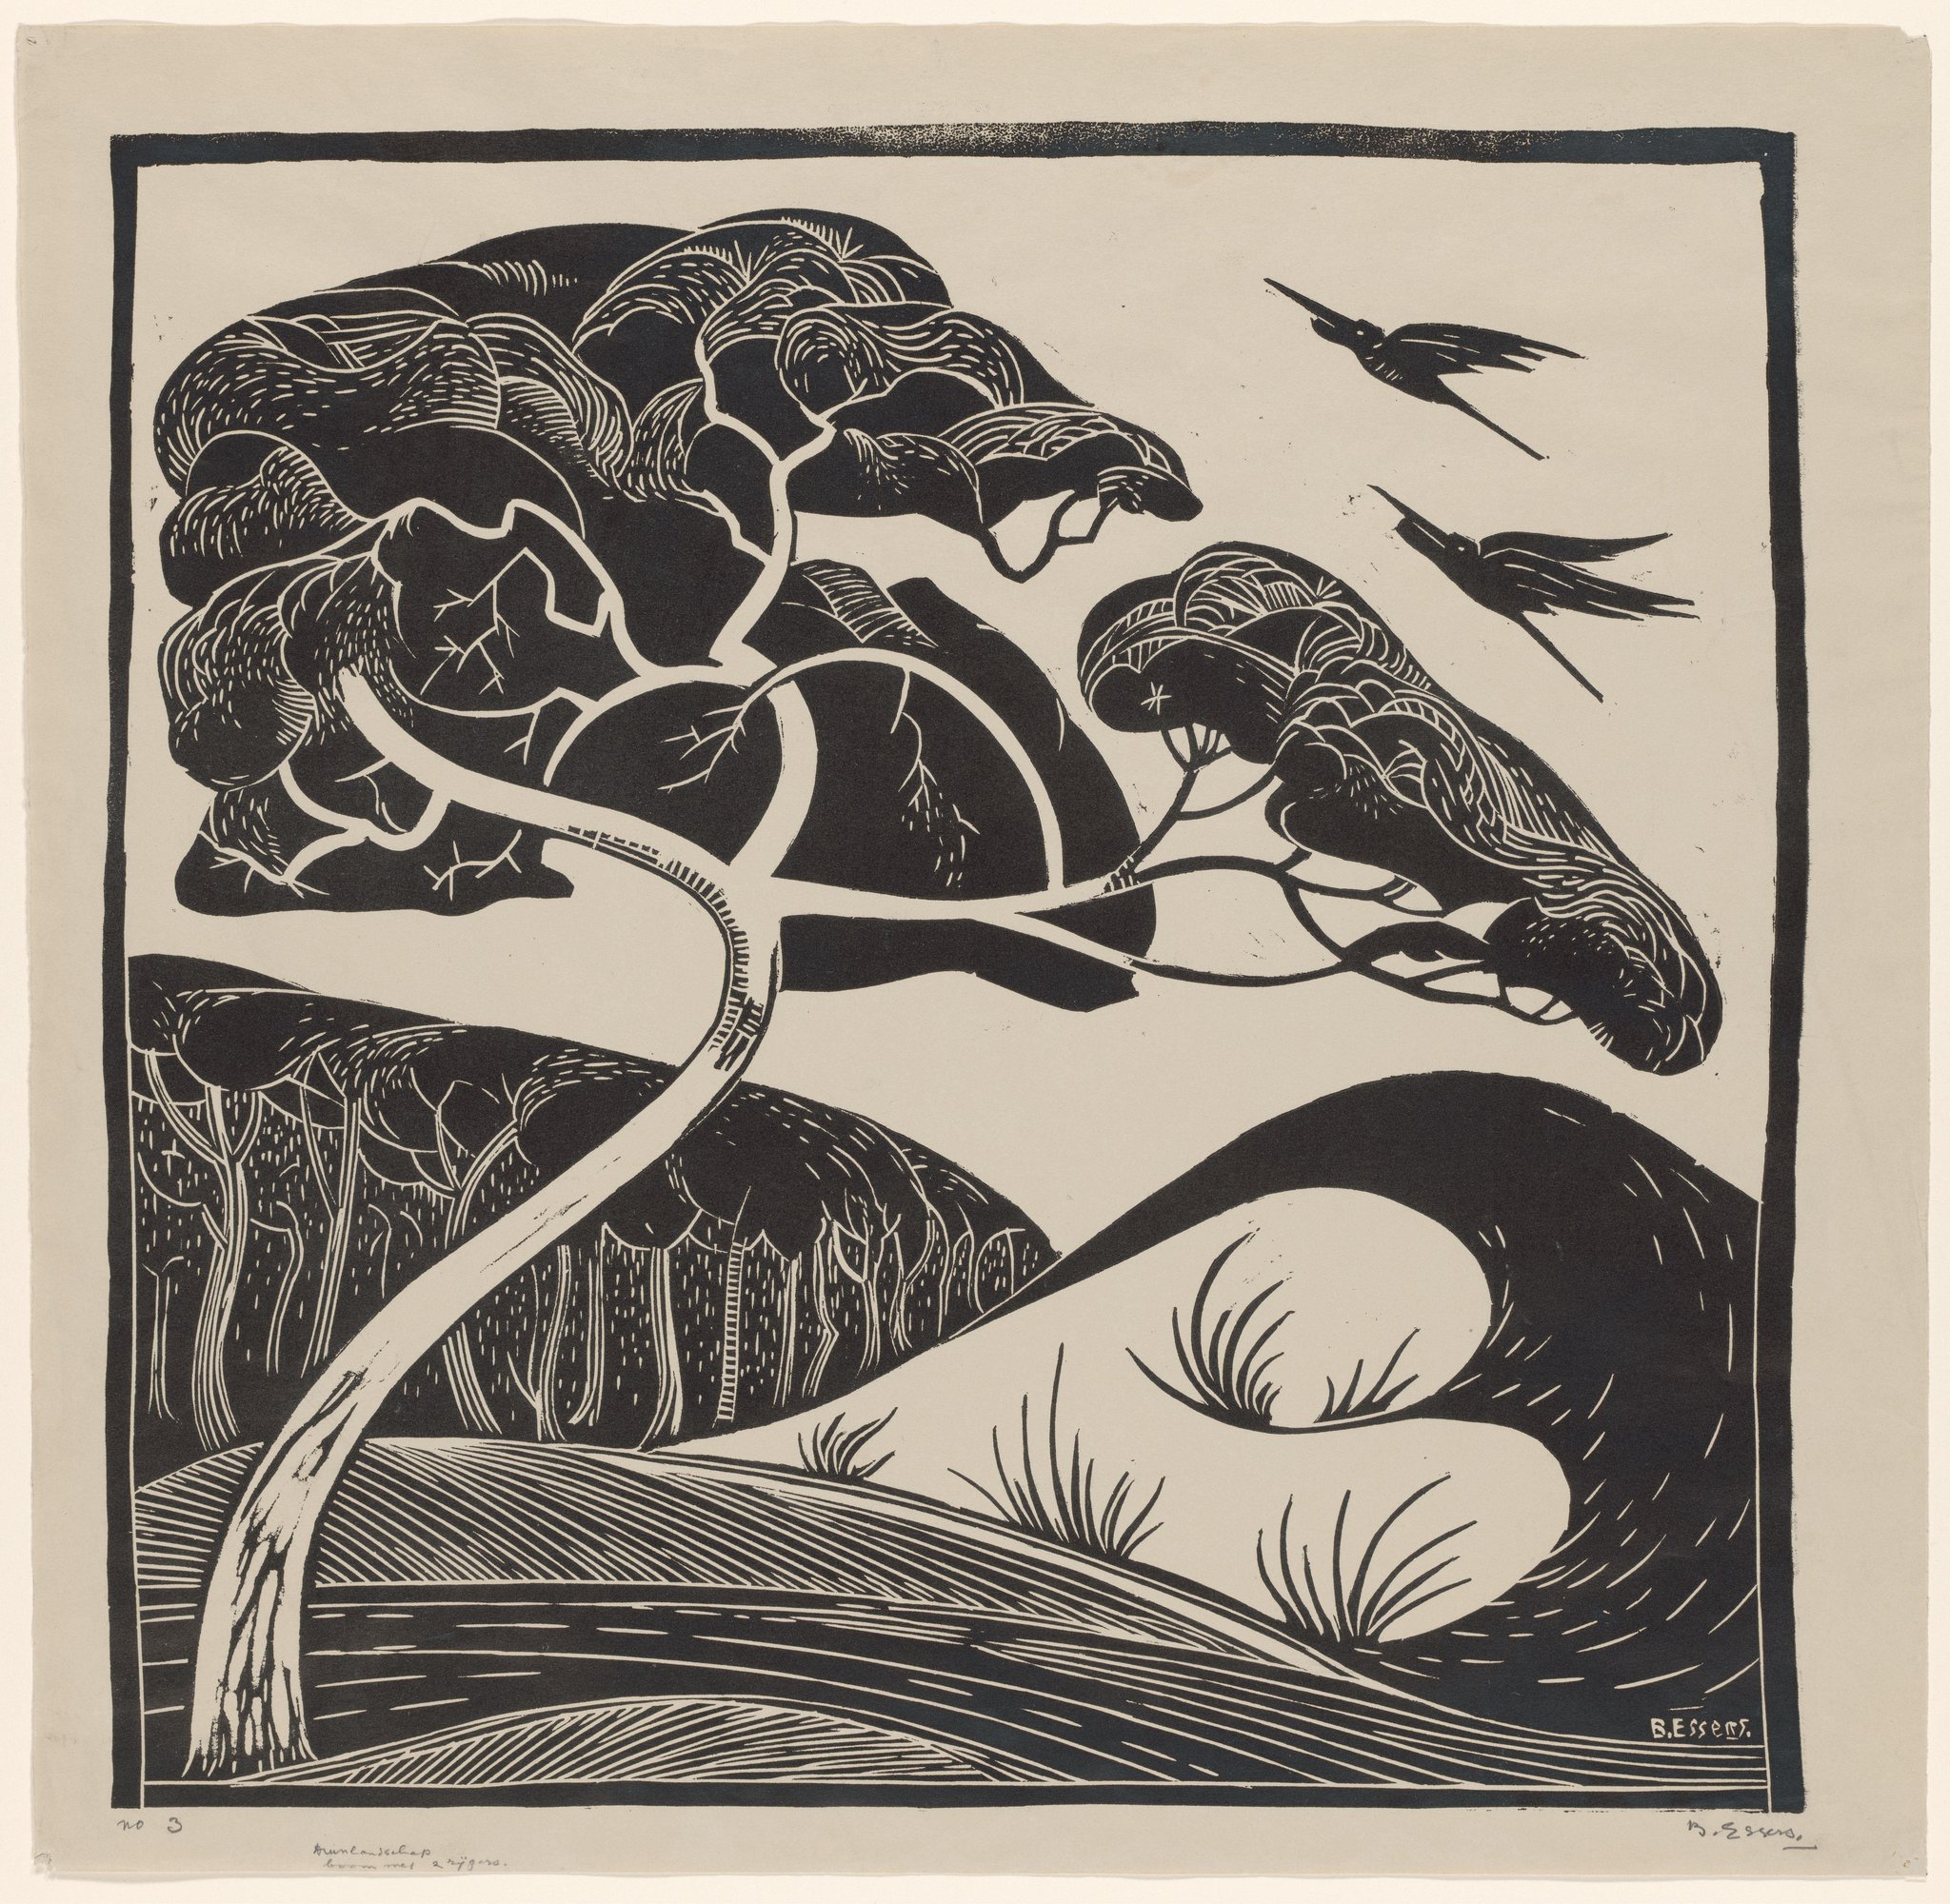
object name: print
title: Duinlandschap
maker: bernard essers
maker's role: print maker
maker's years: 1893-1945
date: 1922-1923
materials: paper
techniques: woodcut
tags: trees, shore-birds and wading-birds: heron, dunes (sea not visible); in the dunes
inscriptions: collector's mark: Lugt 2228, inscription